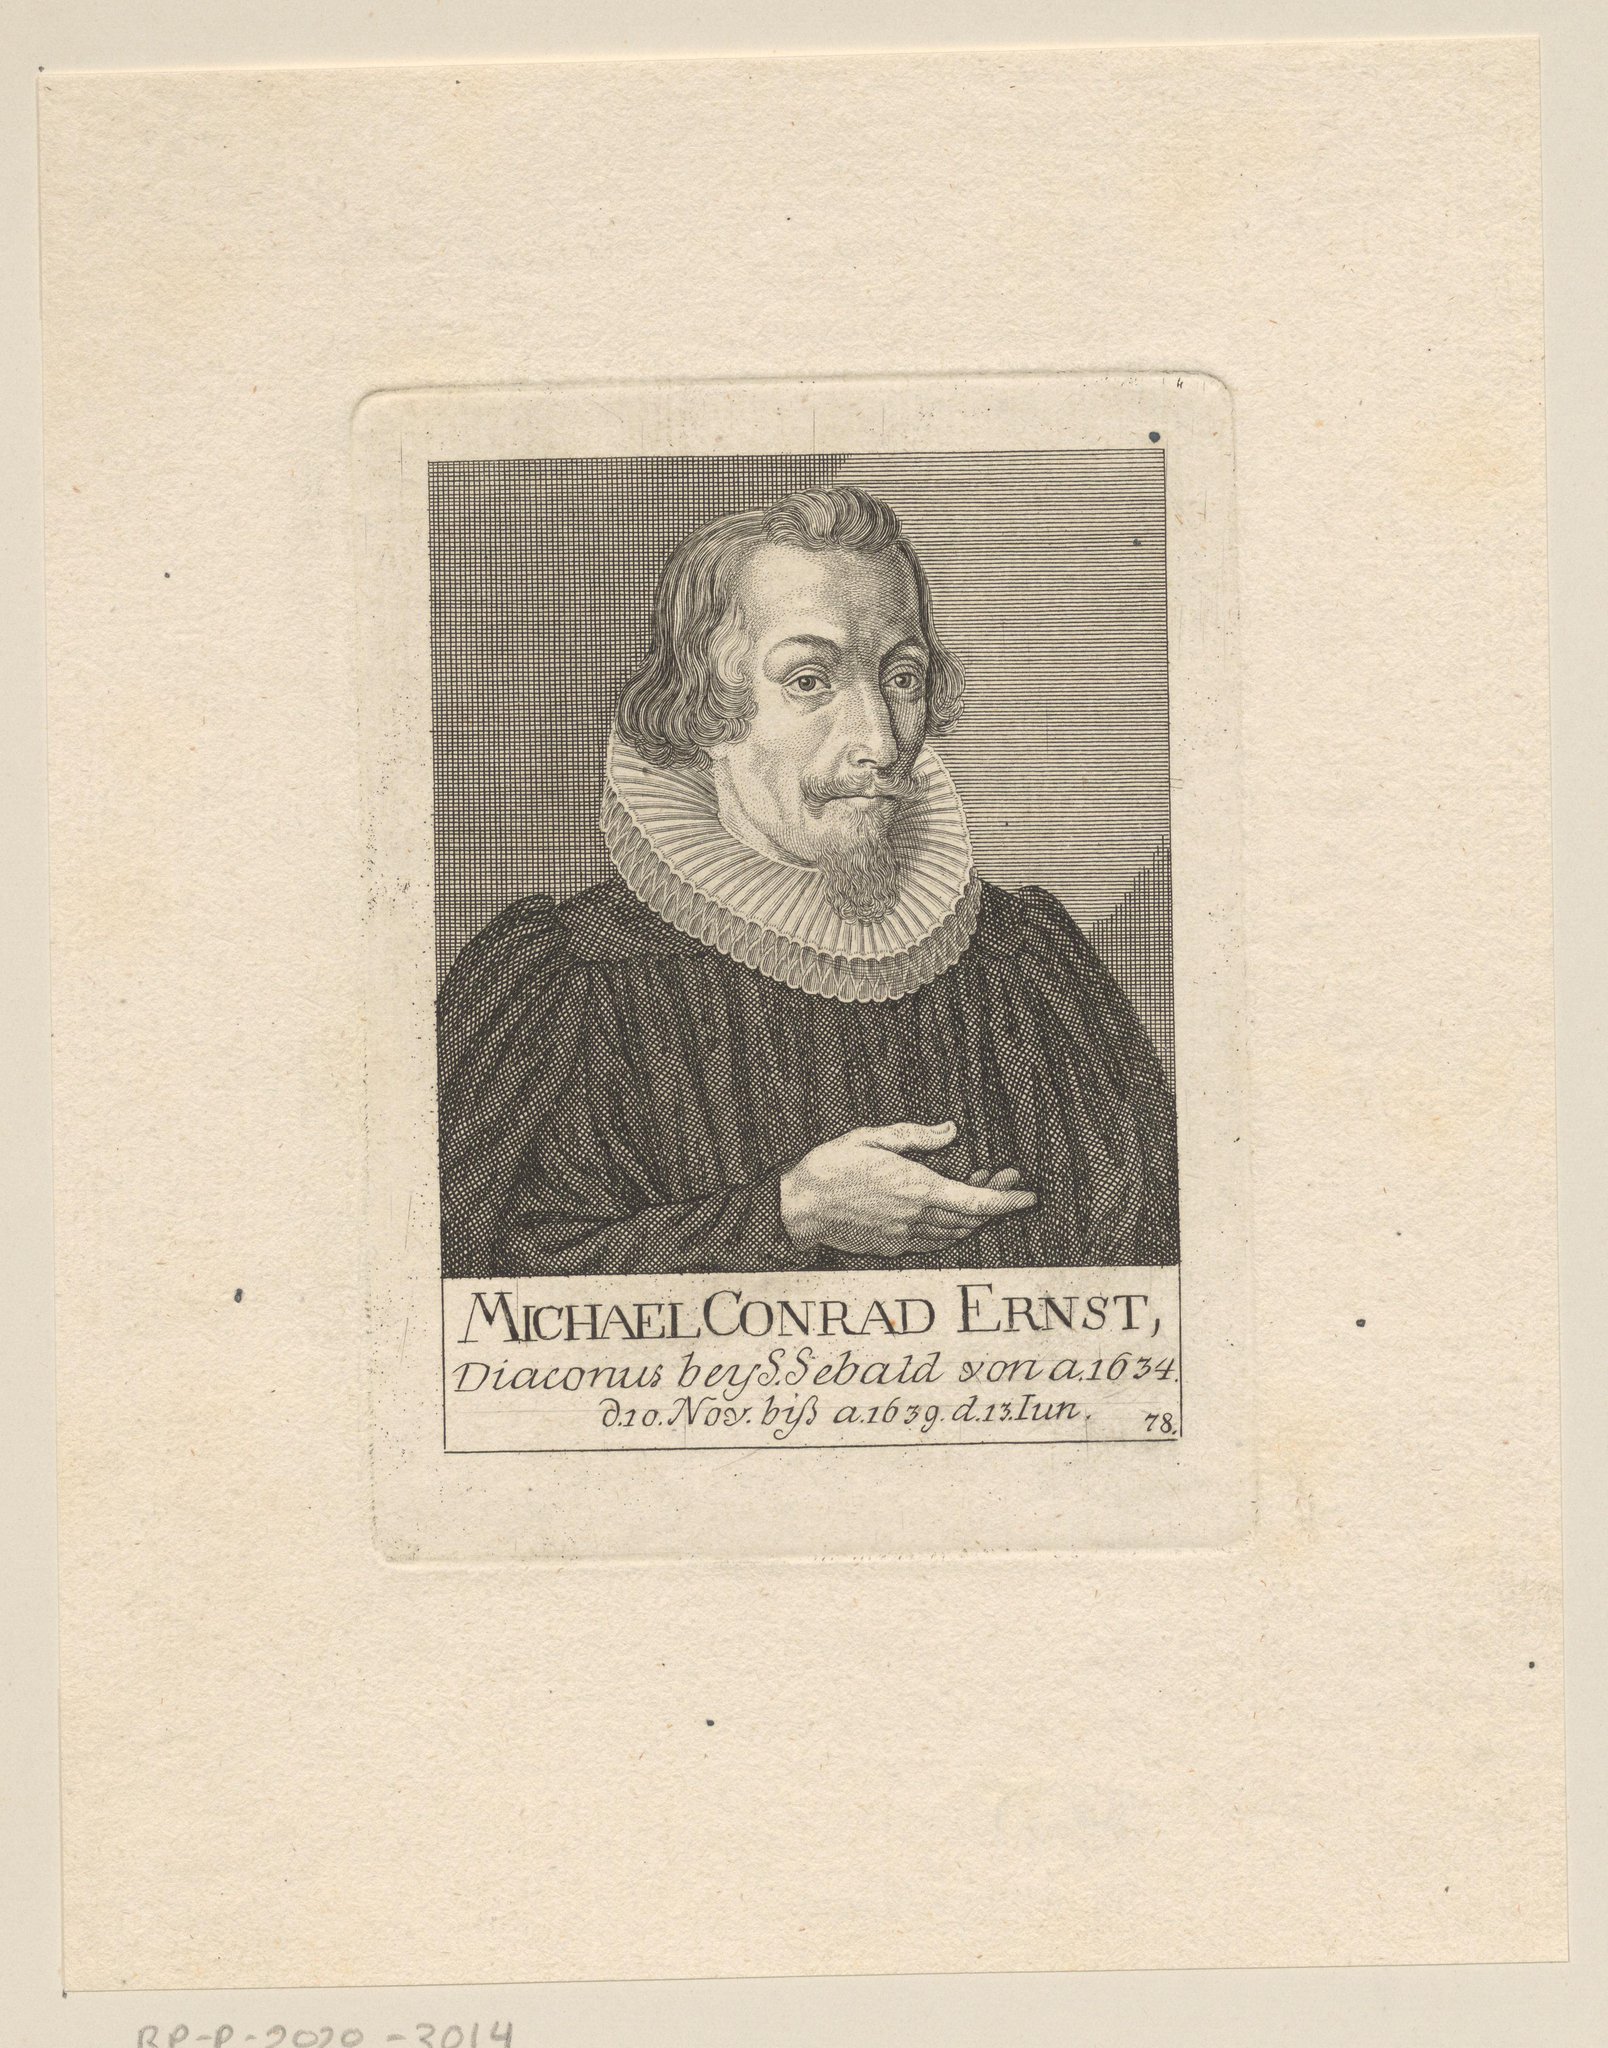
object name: print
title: Portret van Michael Conrad Ernst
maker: Anonymous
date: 1756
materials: paper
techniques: engraving, etching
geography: germany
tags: historical persons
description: Prent waarschijnlijk uit: Würfel, Andreas. Diptycha ecclesiae Sebaldianae (...). Neurenberg: Christoph Melchior Roth, 1756.